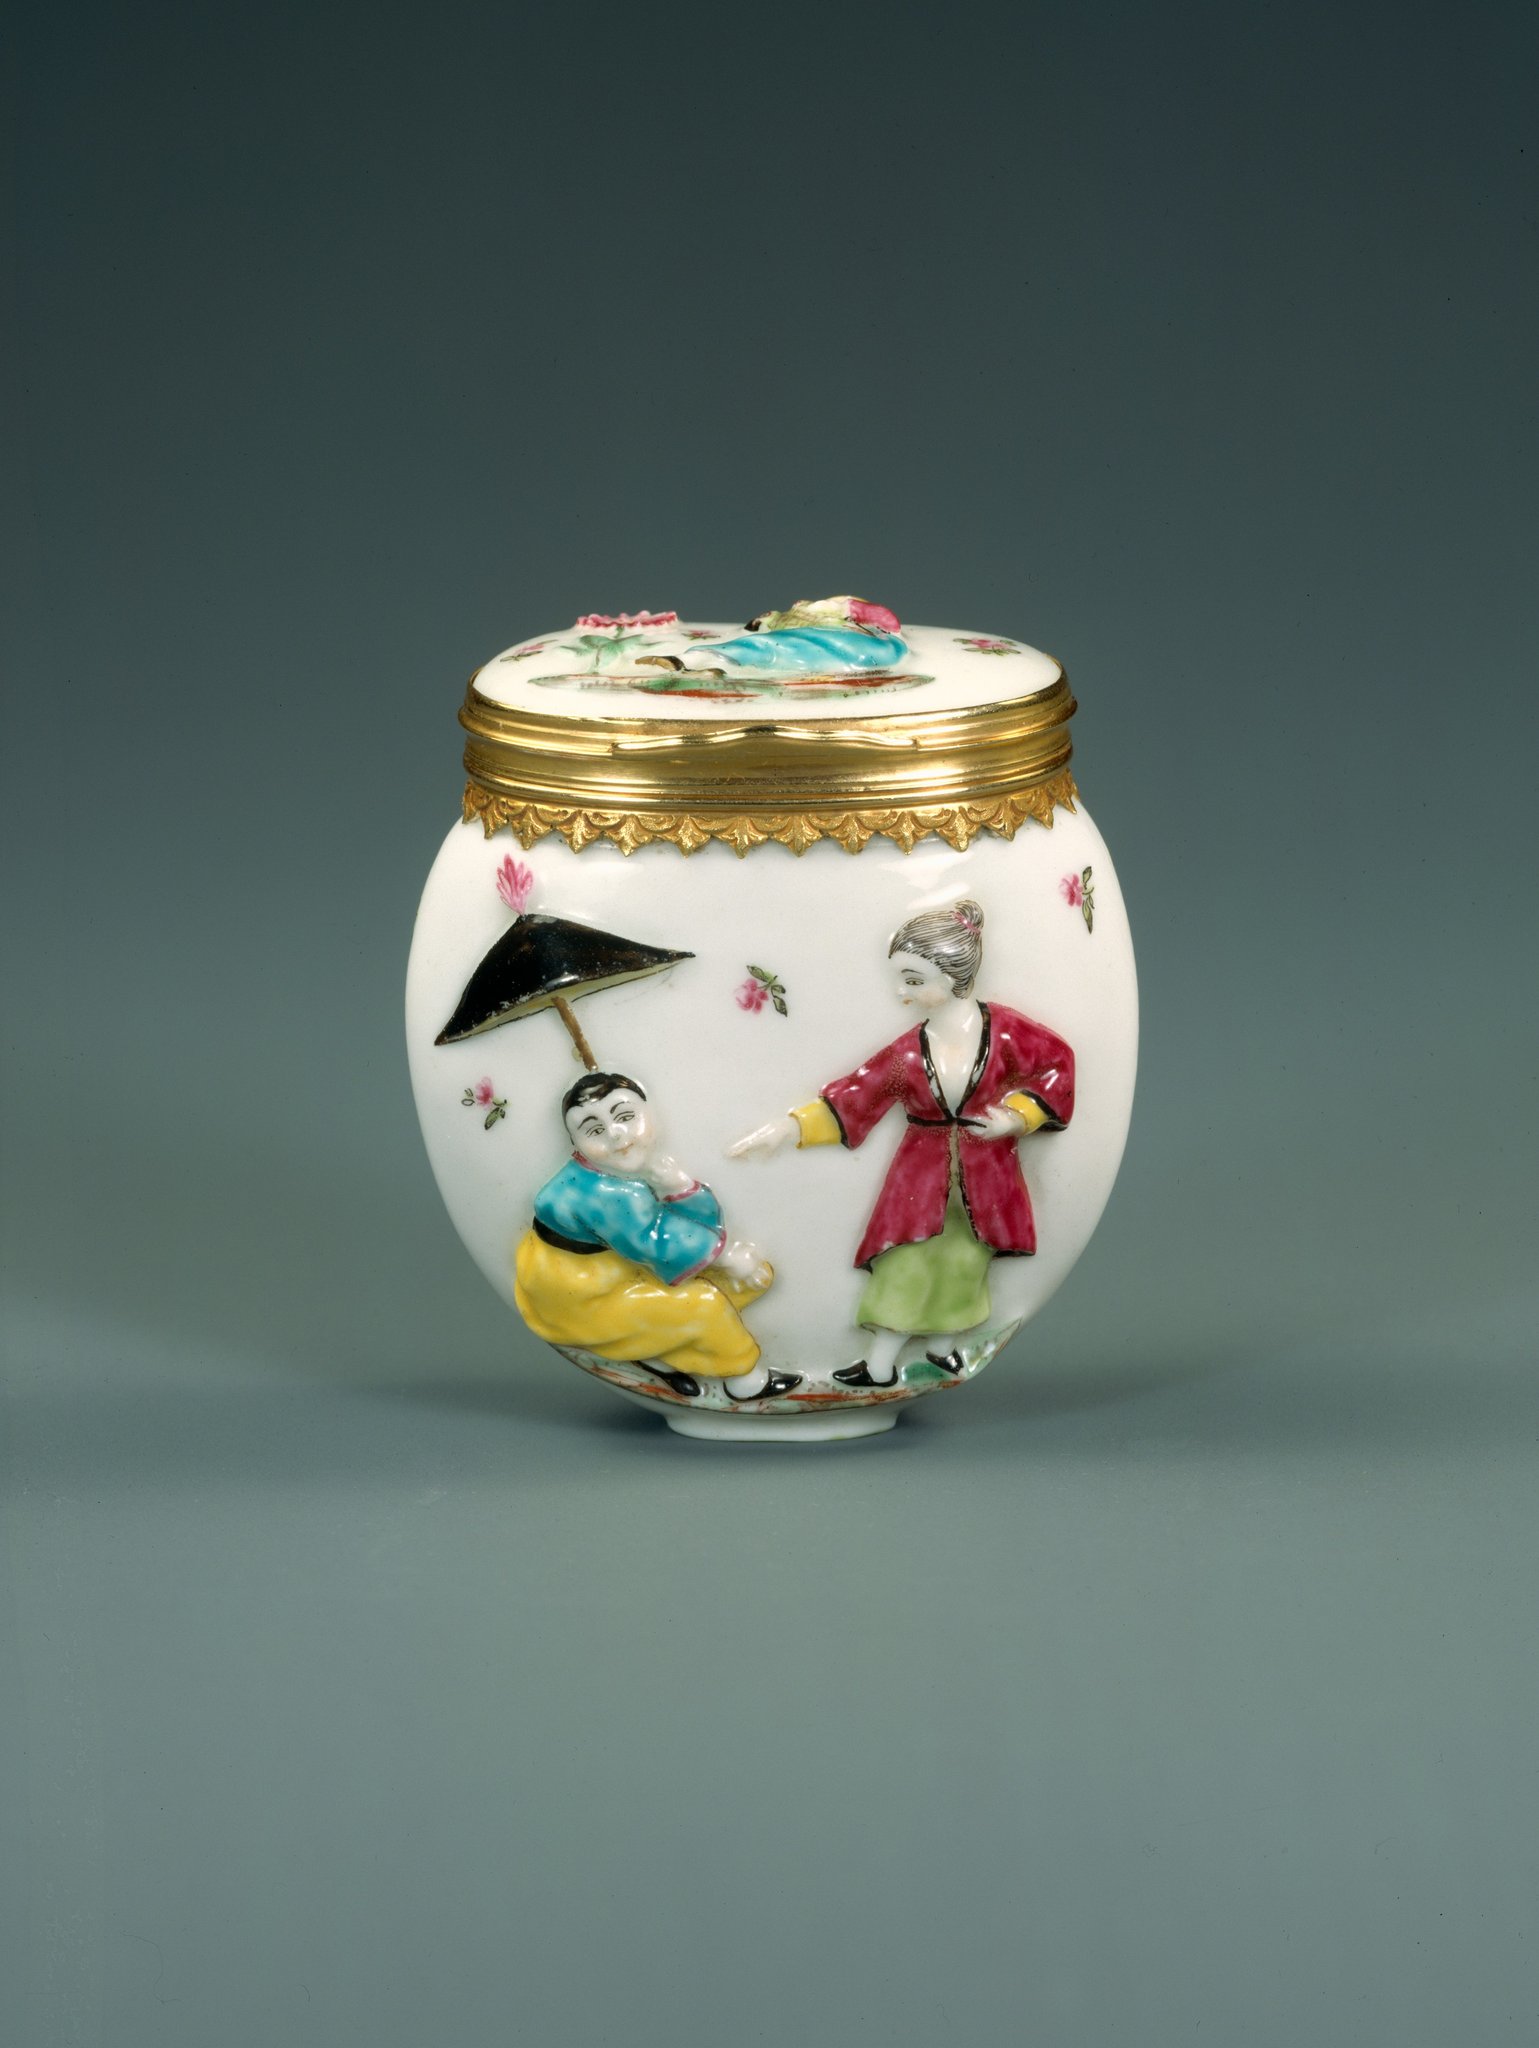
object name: snuffbox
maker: saint james's factory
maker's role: maker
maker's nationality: british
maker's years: 1749-1759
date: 1755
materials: gold, soft paste porcelain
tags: men,women